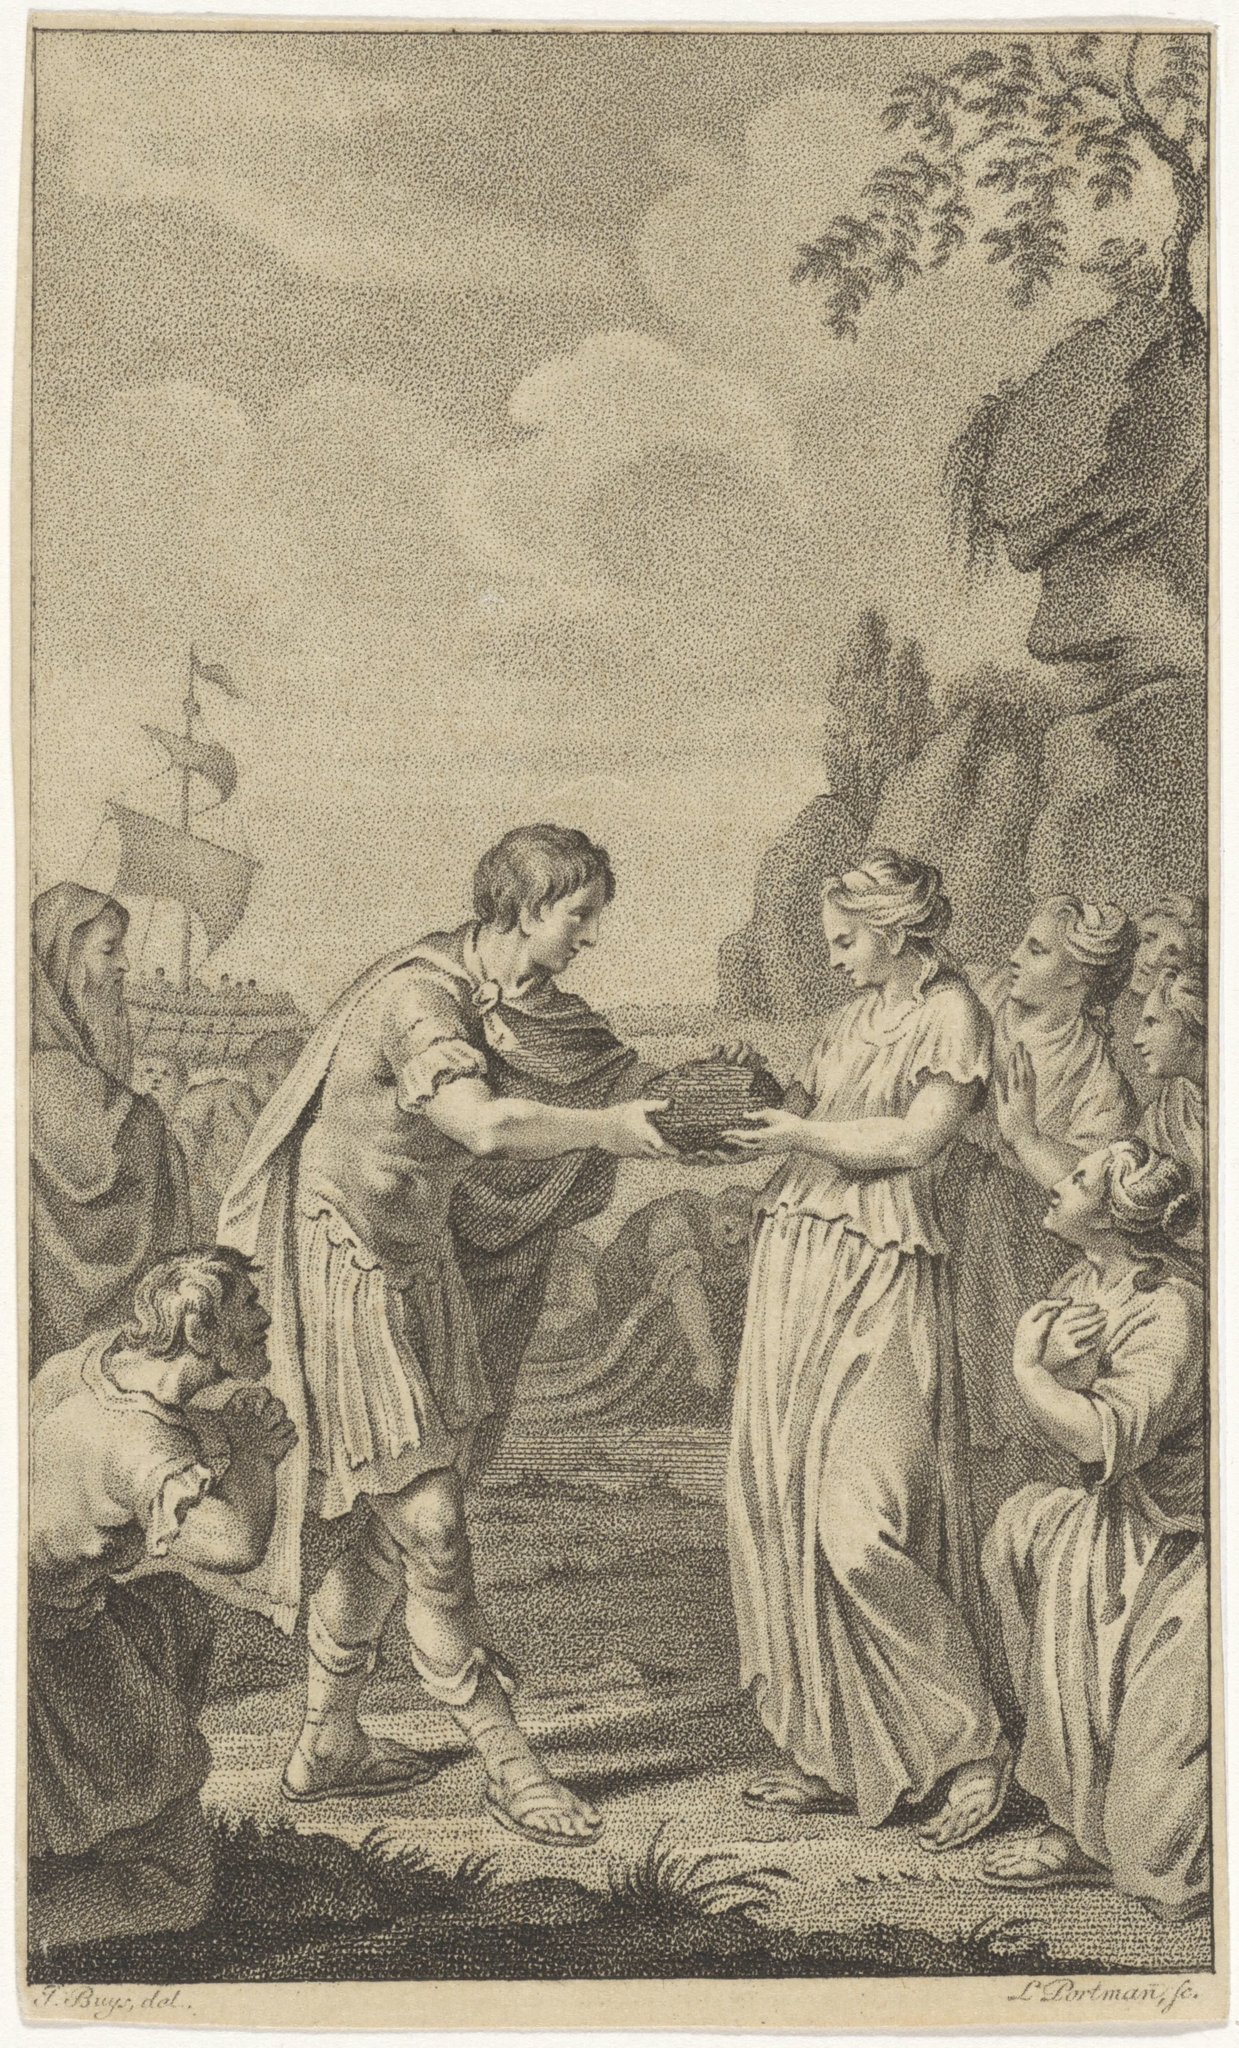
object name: print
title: Aankomst van het beeld van Cybele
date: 1796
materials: paper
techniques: stippled etching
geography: amsterdam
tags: when the statue of cybele is brought to rome, p. cornelius scipio nasica is chosen to meet the goddess in the harbour of ostia, and ordered to bring her to rome with the greatest pomp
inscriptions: collector's mark: Lugt 2228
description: Publius Cornelius Scipio Nasica ontvangt het beeld van Cybele, de godin van de aarde, in de haven van Ostia. Hij moet het zo spoedig mogelijk naar Rome brengen.